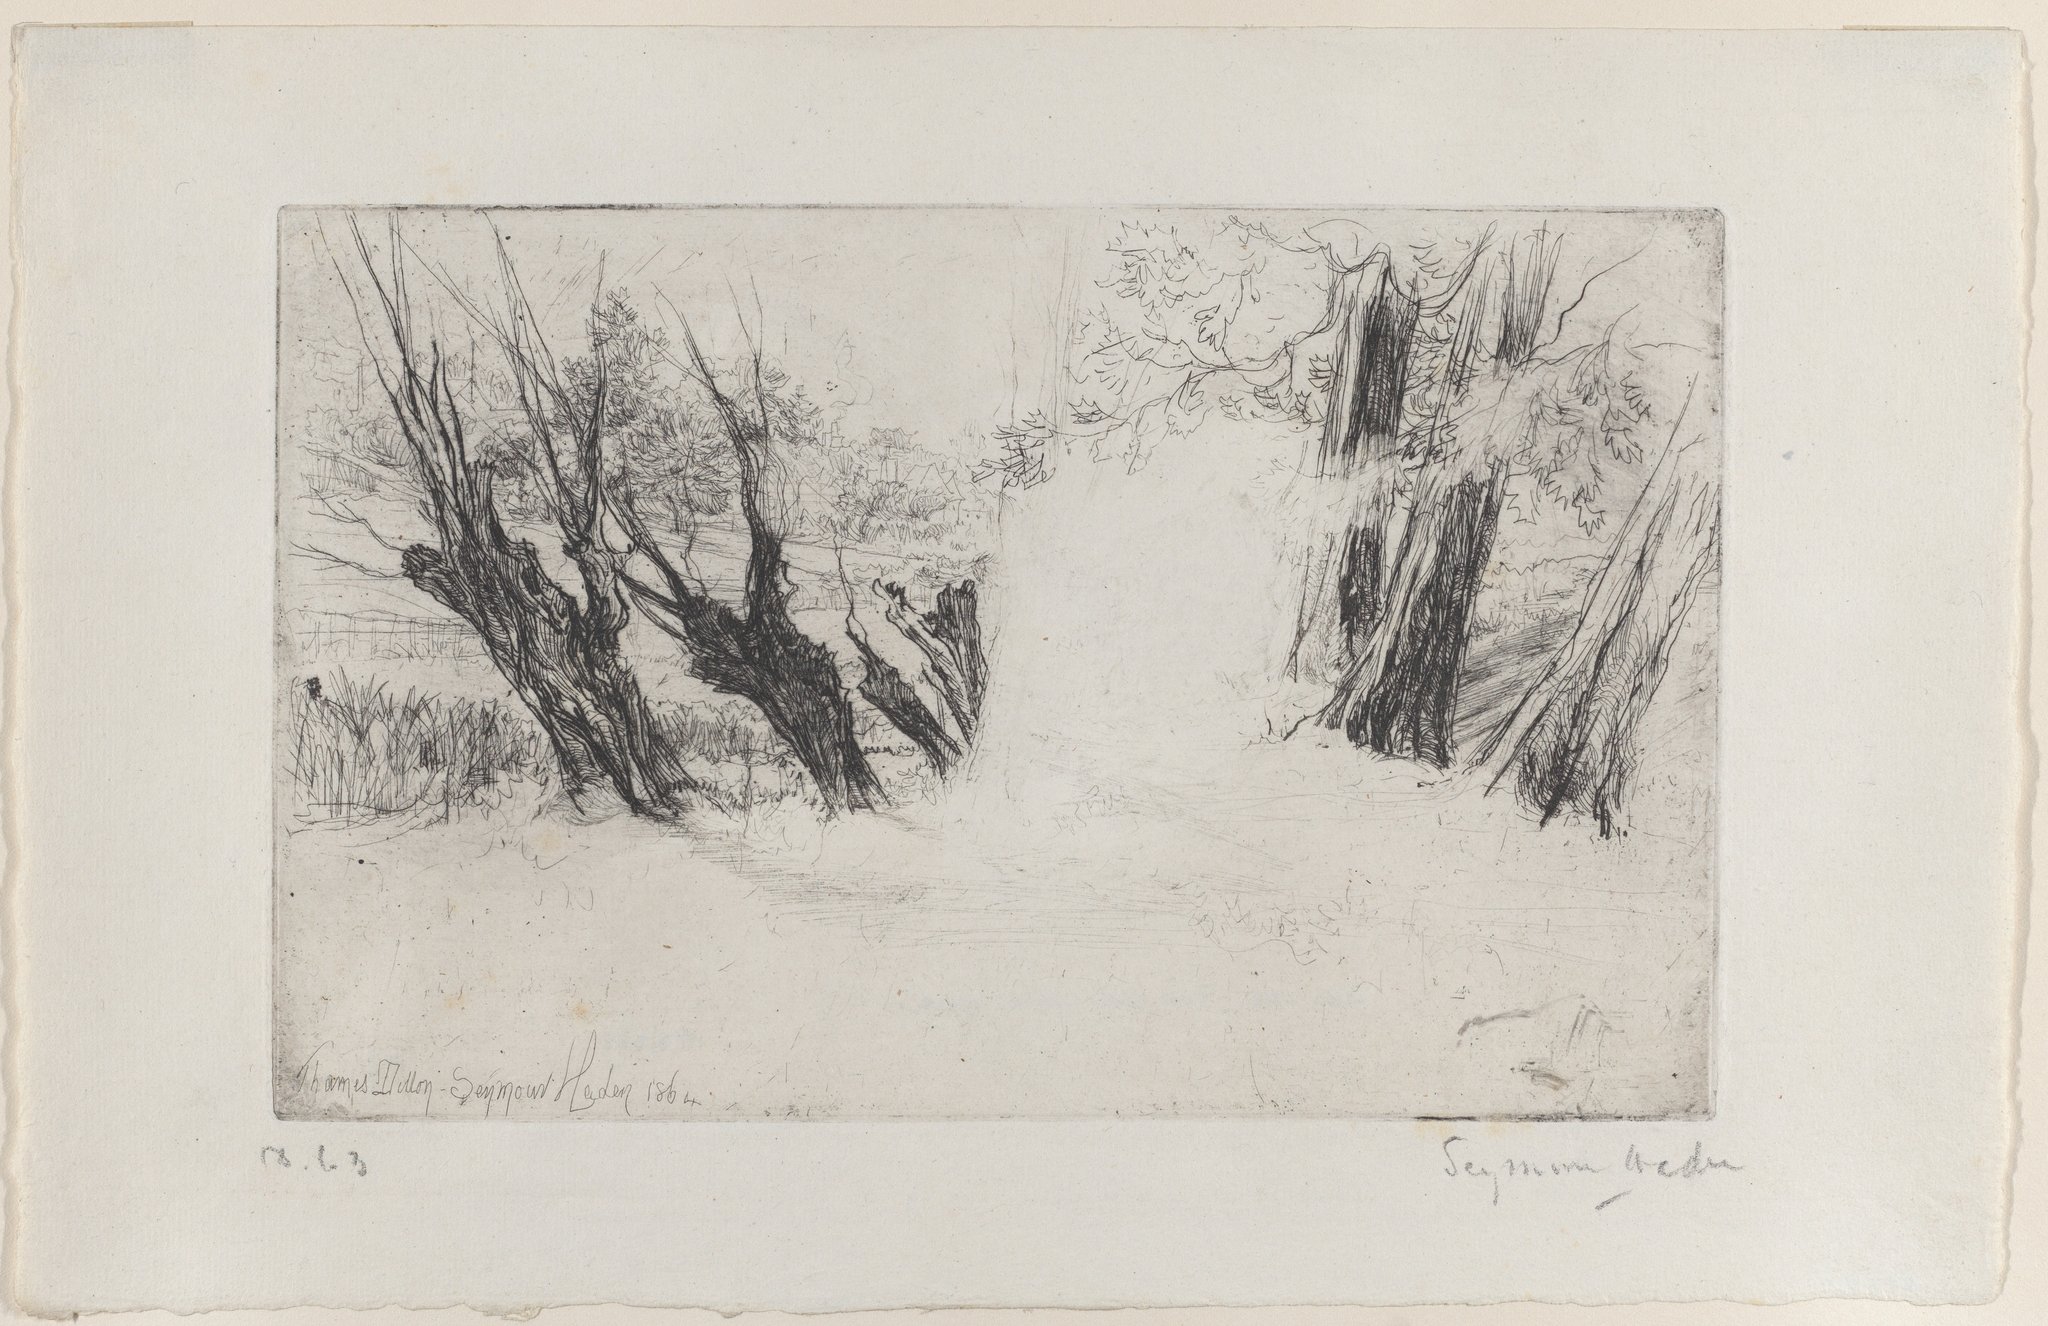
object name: print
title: The Lovers' Walk, No. 1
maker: francis seymour haden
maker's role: artist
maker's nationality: british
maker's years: 1818-1910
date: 1864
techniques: drypoint, etching